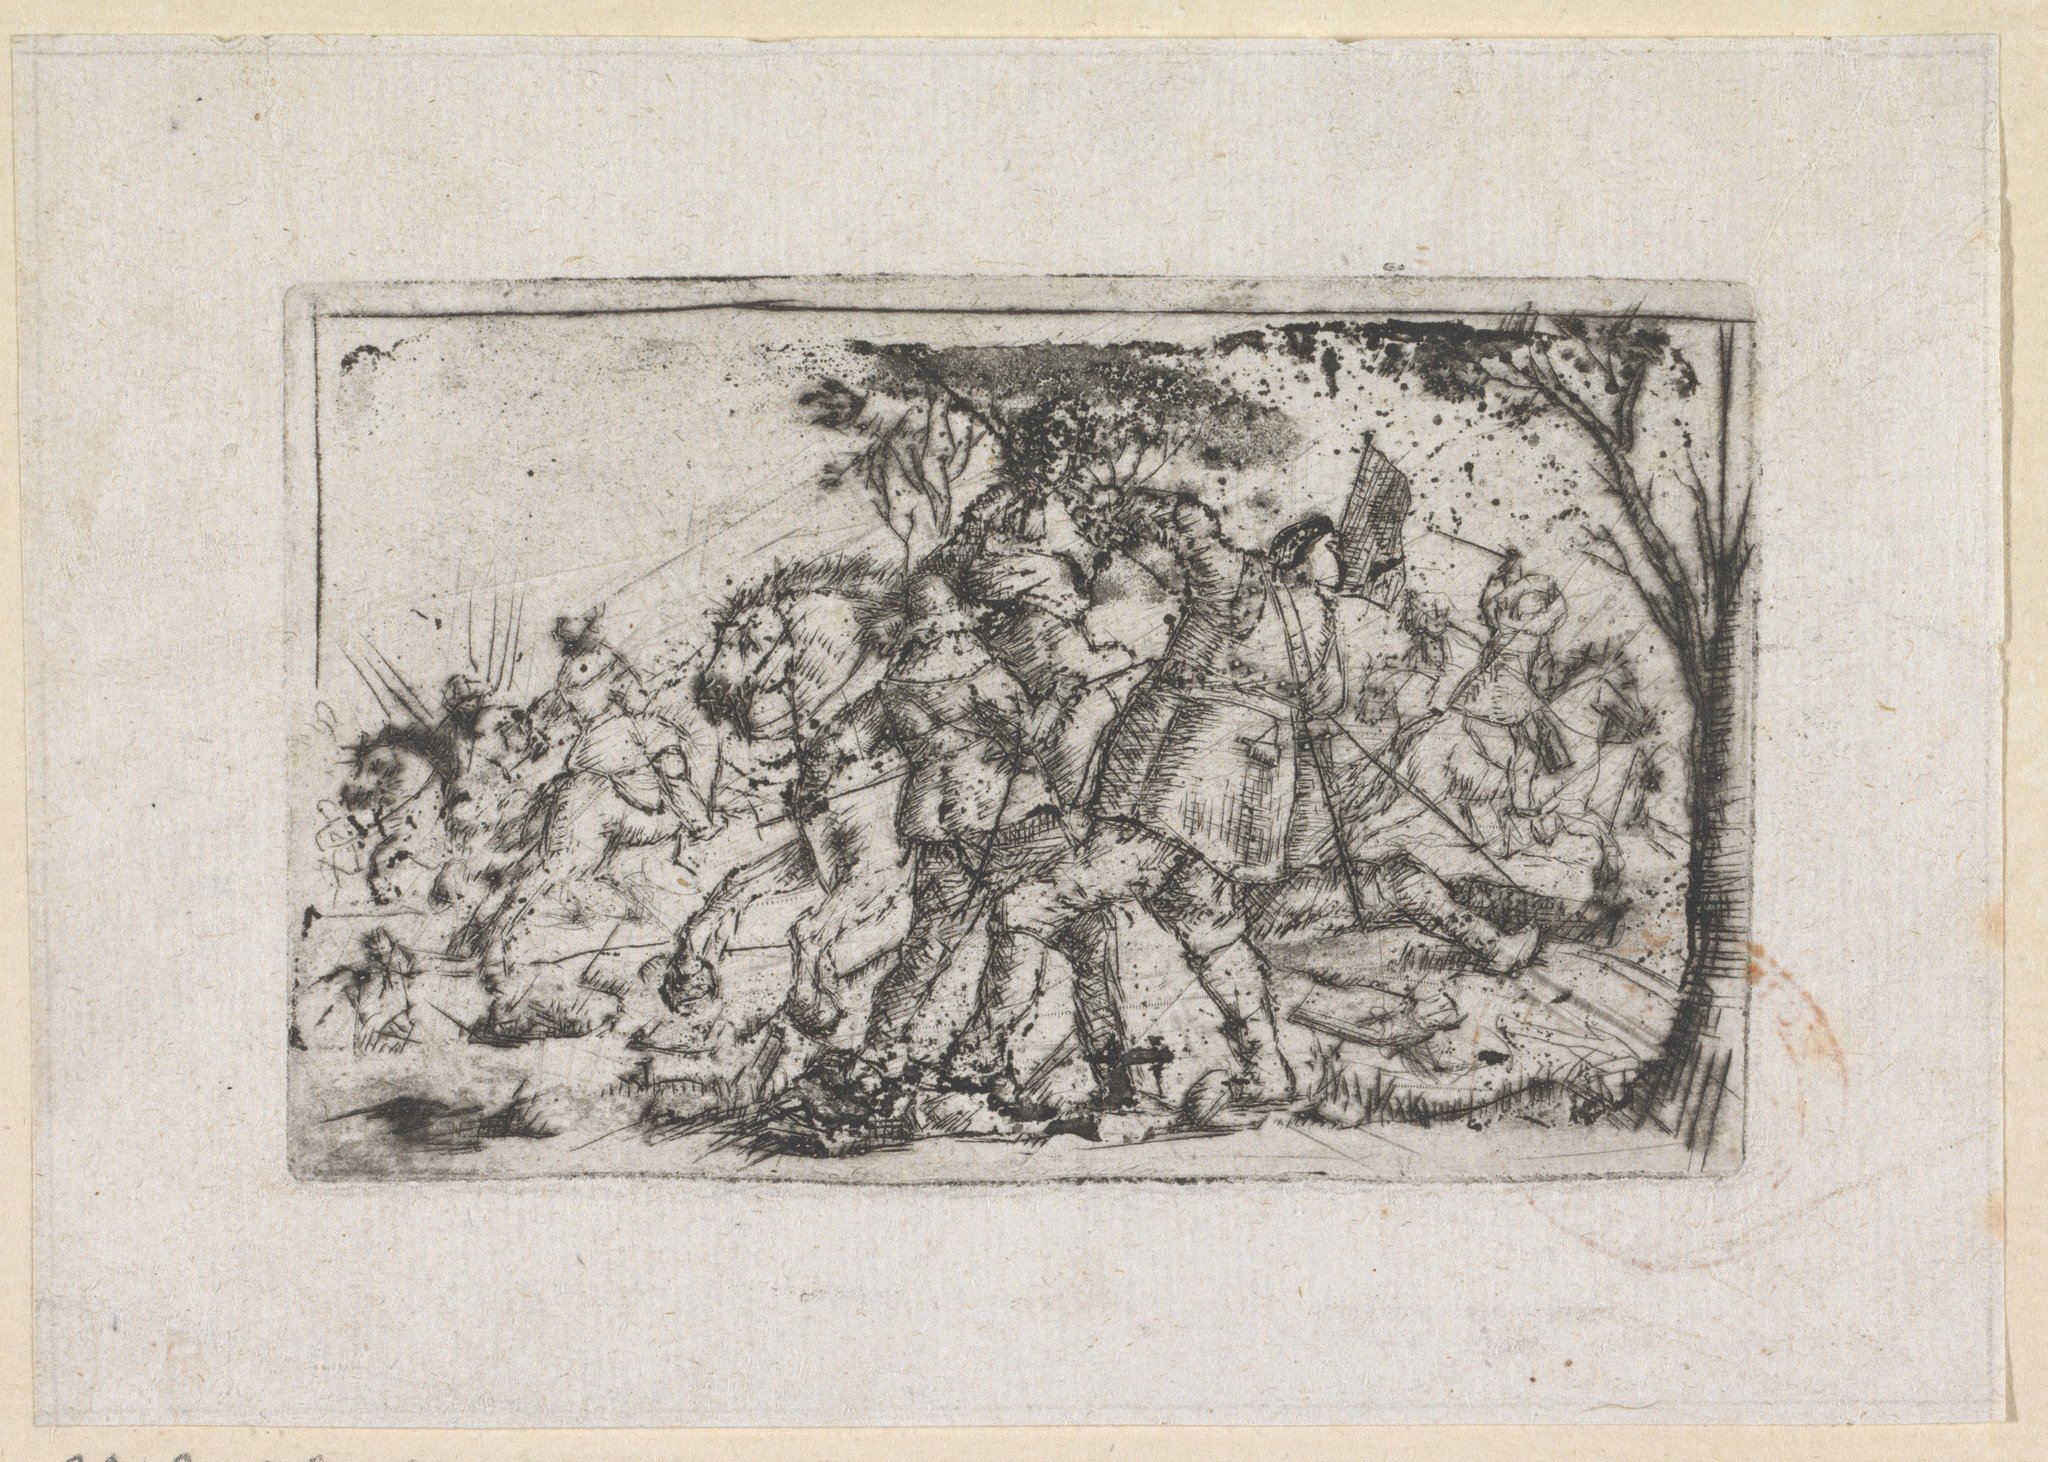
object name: print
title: Ruitergevecht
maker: Anonymous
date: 1600-1700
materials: paper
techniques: drypoint, engraving, roulette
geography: netherlands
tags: land forces (+ cavalry, horsemen), battle (+ cavalry, horsemen)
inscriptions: collector's mark: Lugt 240